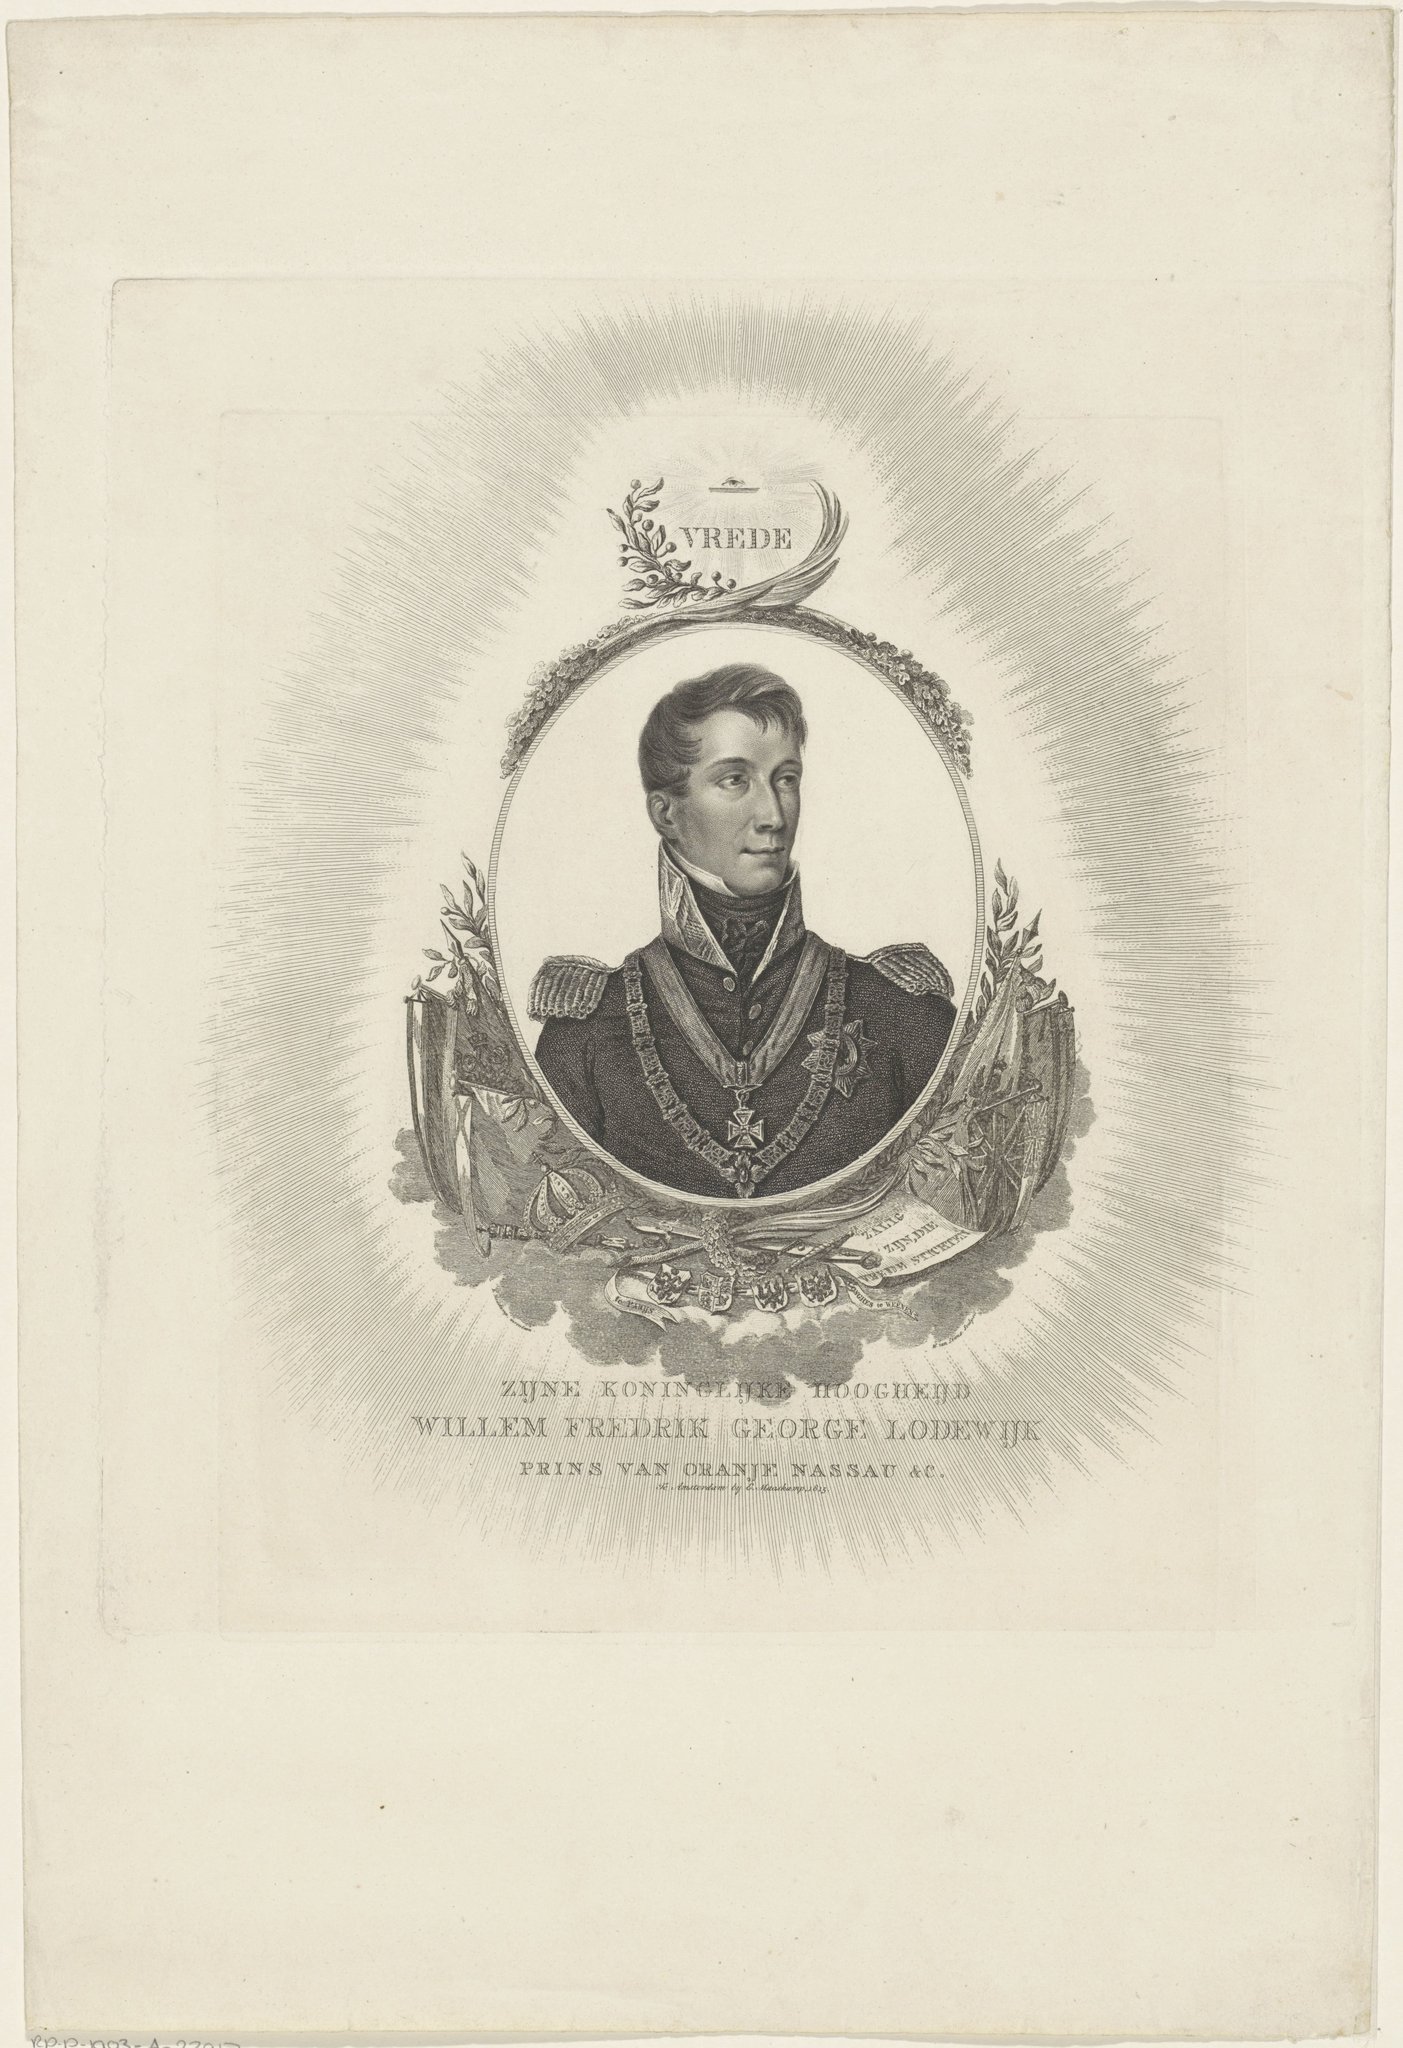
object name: print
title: Portret van Willem II, koning der Nederlanden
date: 1815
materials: paper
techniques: engraving, etching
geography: amsterdam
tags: the hague, william ii of the netherlands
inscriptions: collector's mark: Lugt 2166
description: De hier vermelde titel verwijst naar de hoogst verkregen titel van de geportretteerde, niet per se naar de titel die de geportretteerde op deze voorstelling draagt.